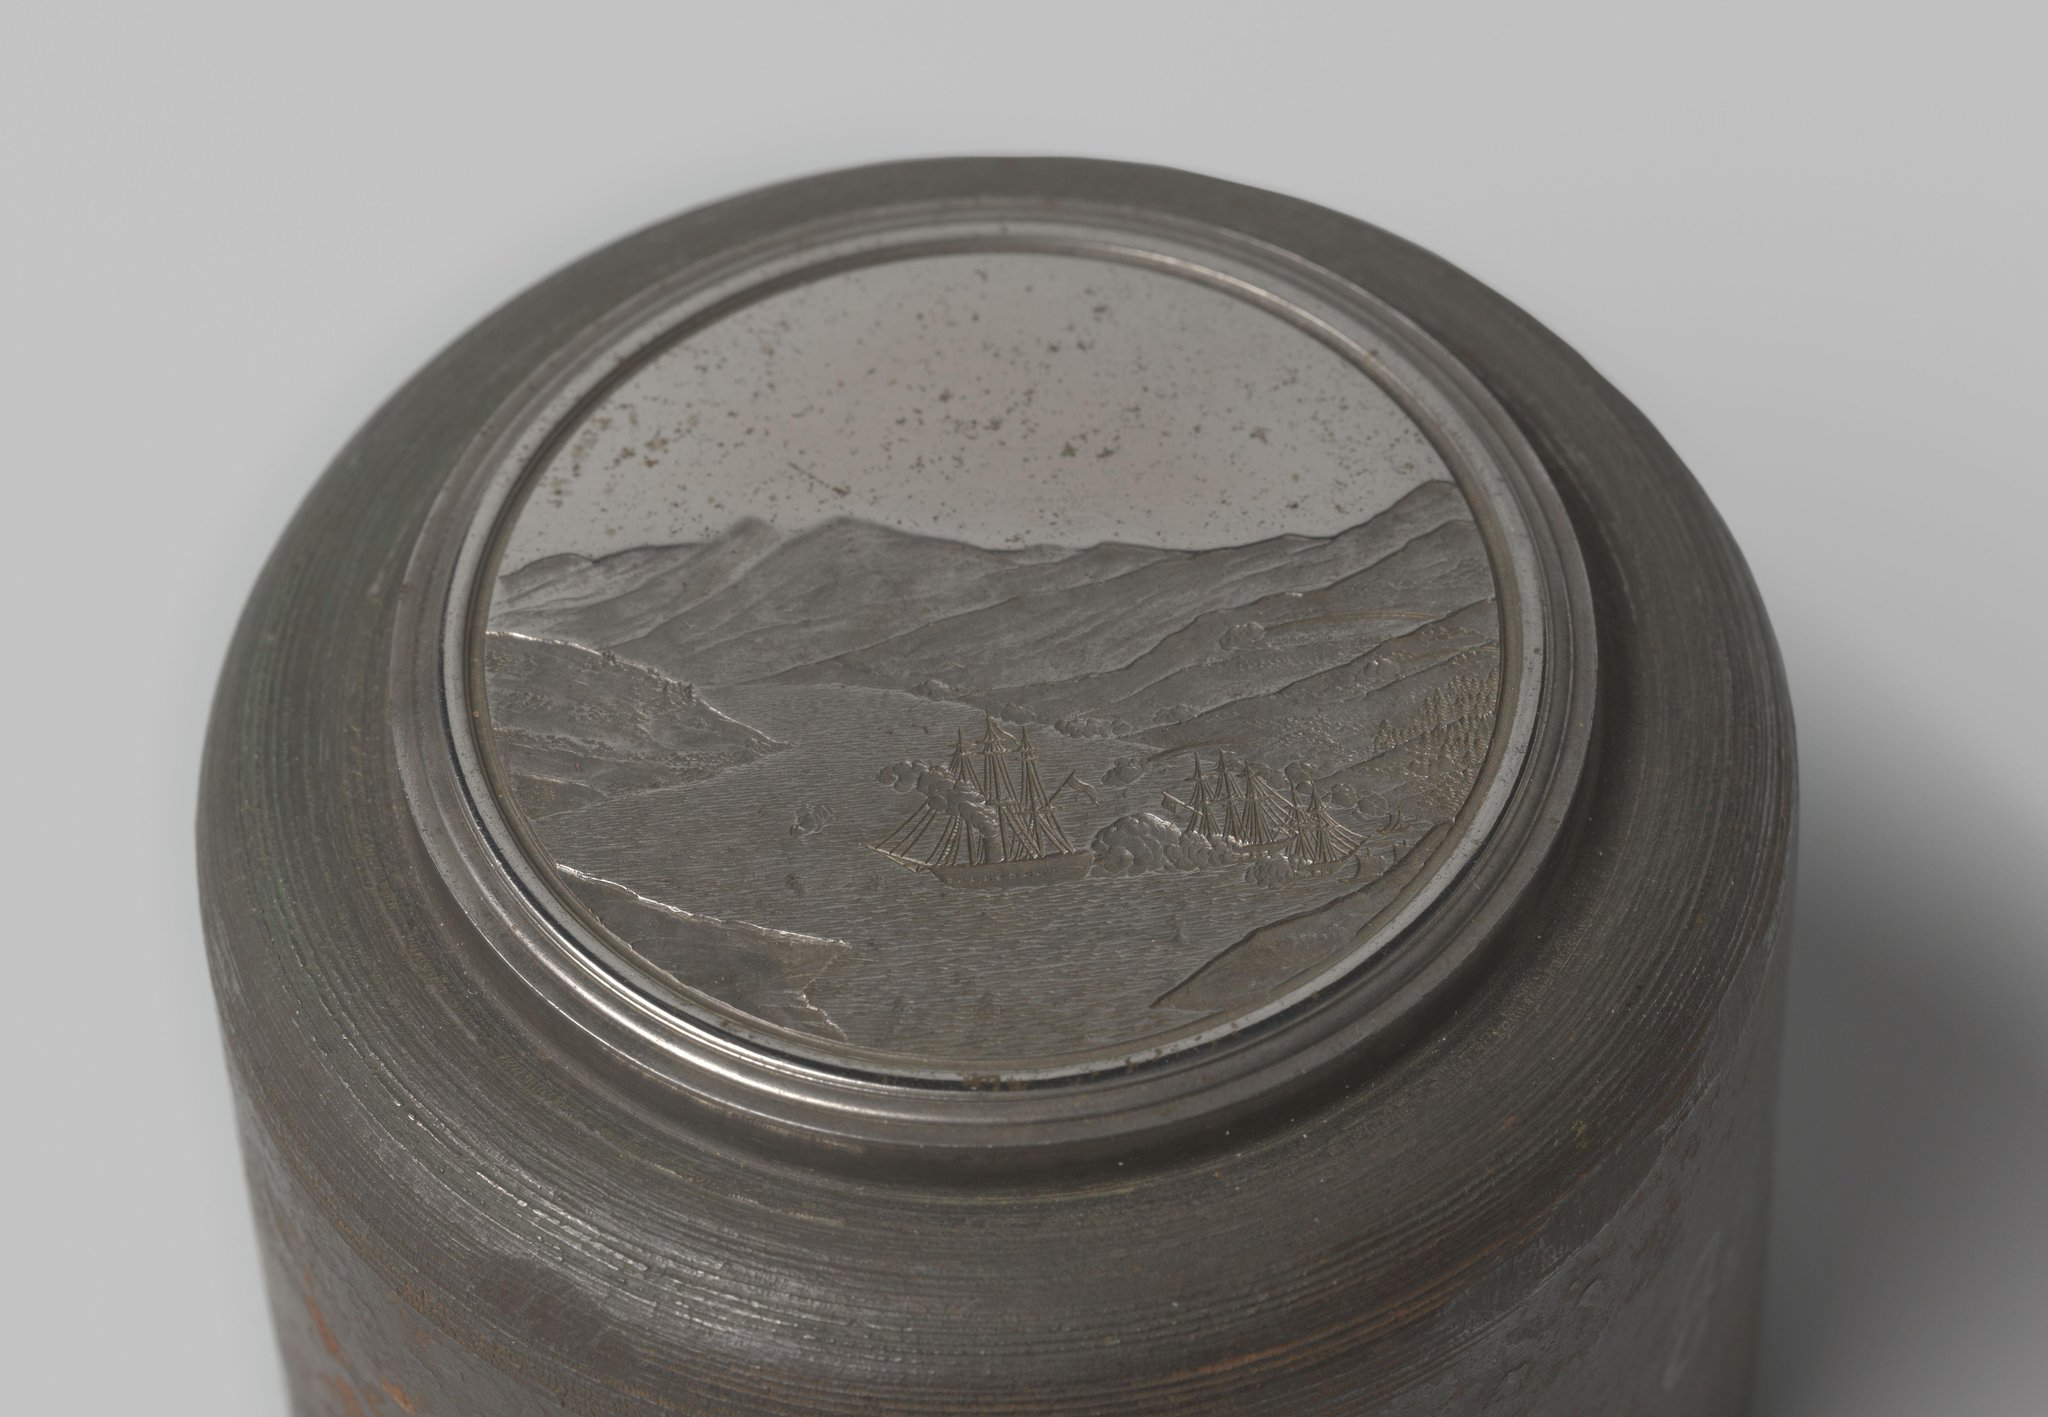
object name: stamp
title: Penningstempel Simonoseki; de voorzijde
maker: Anonymous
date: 1888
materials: steel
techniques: casting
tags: the hague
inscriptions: date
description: Penningstempel. Voorzijde van de penning: een baai omringd door heuvels met vurende schepen op de voorgrond.